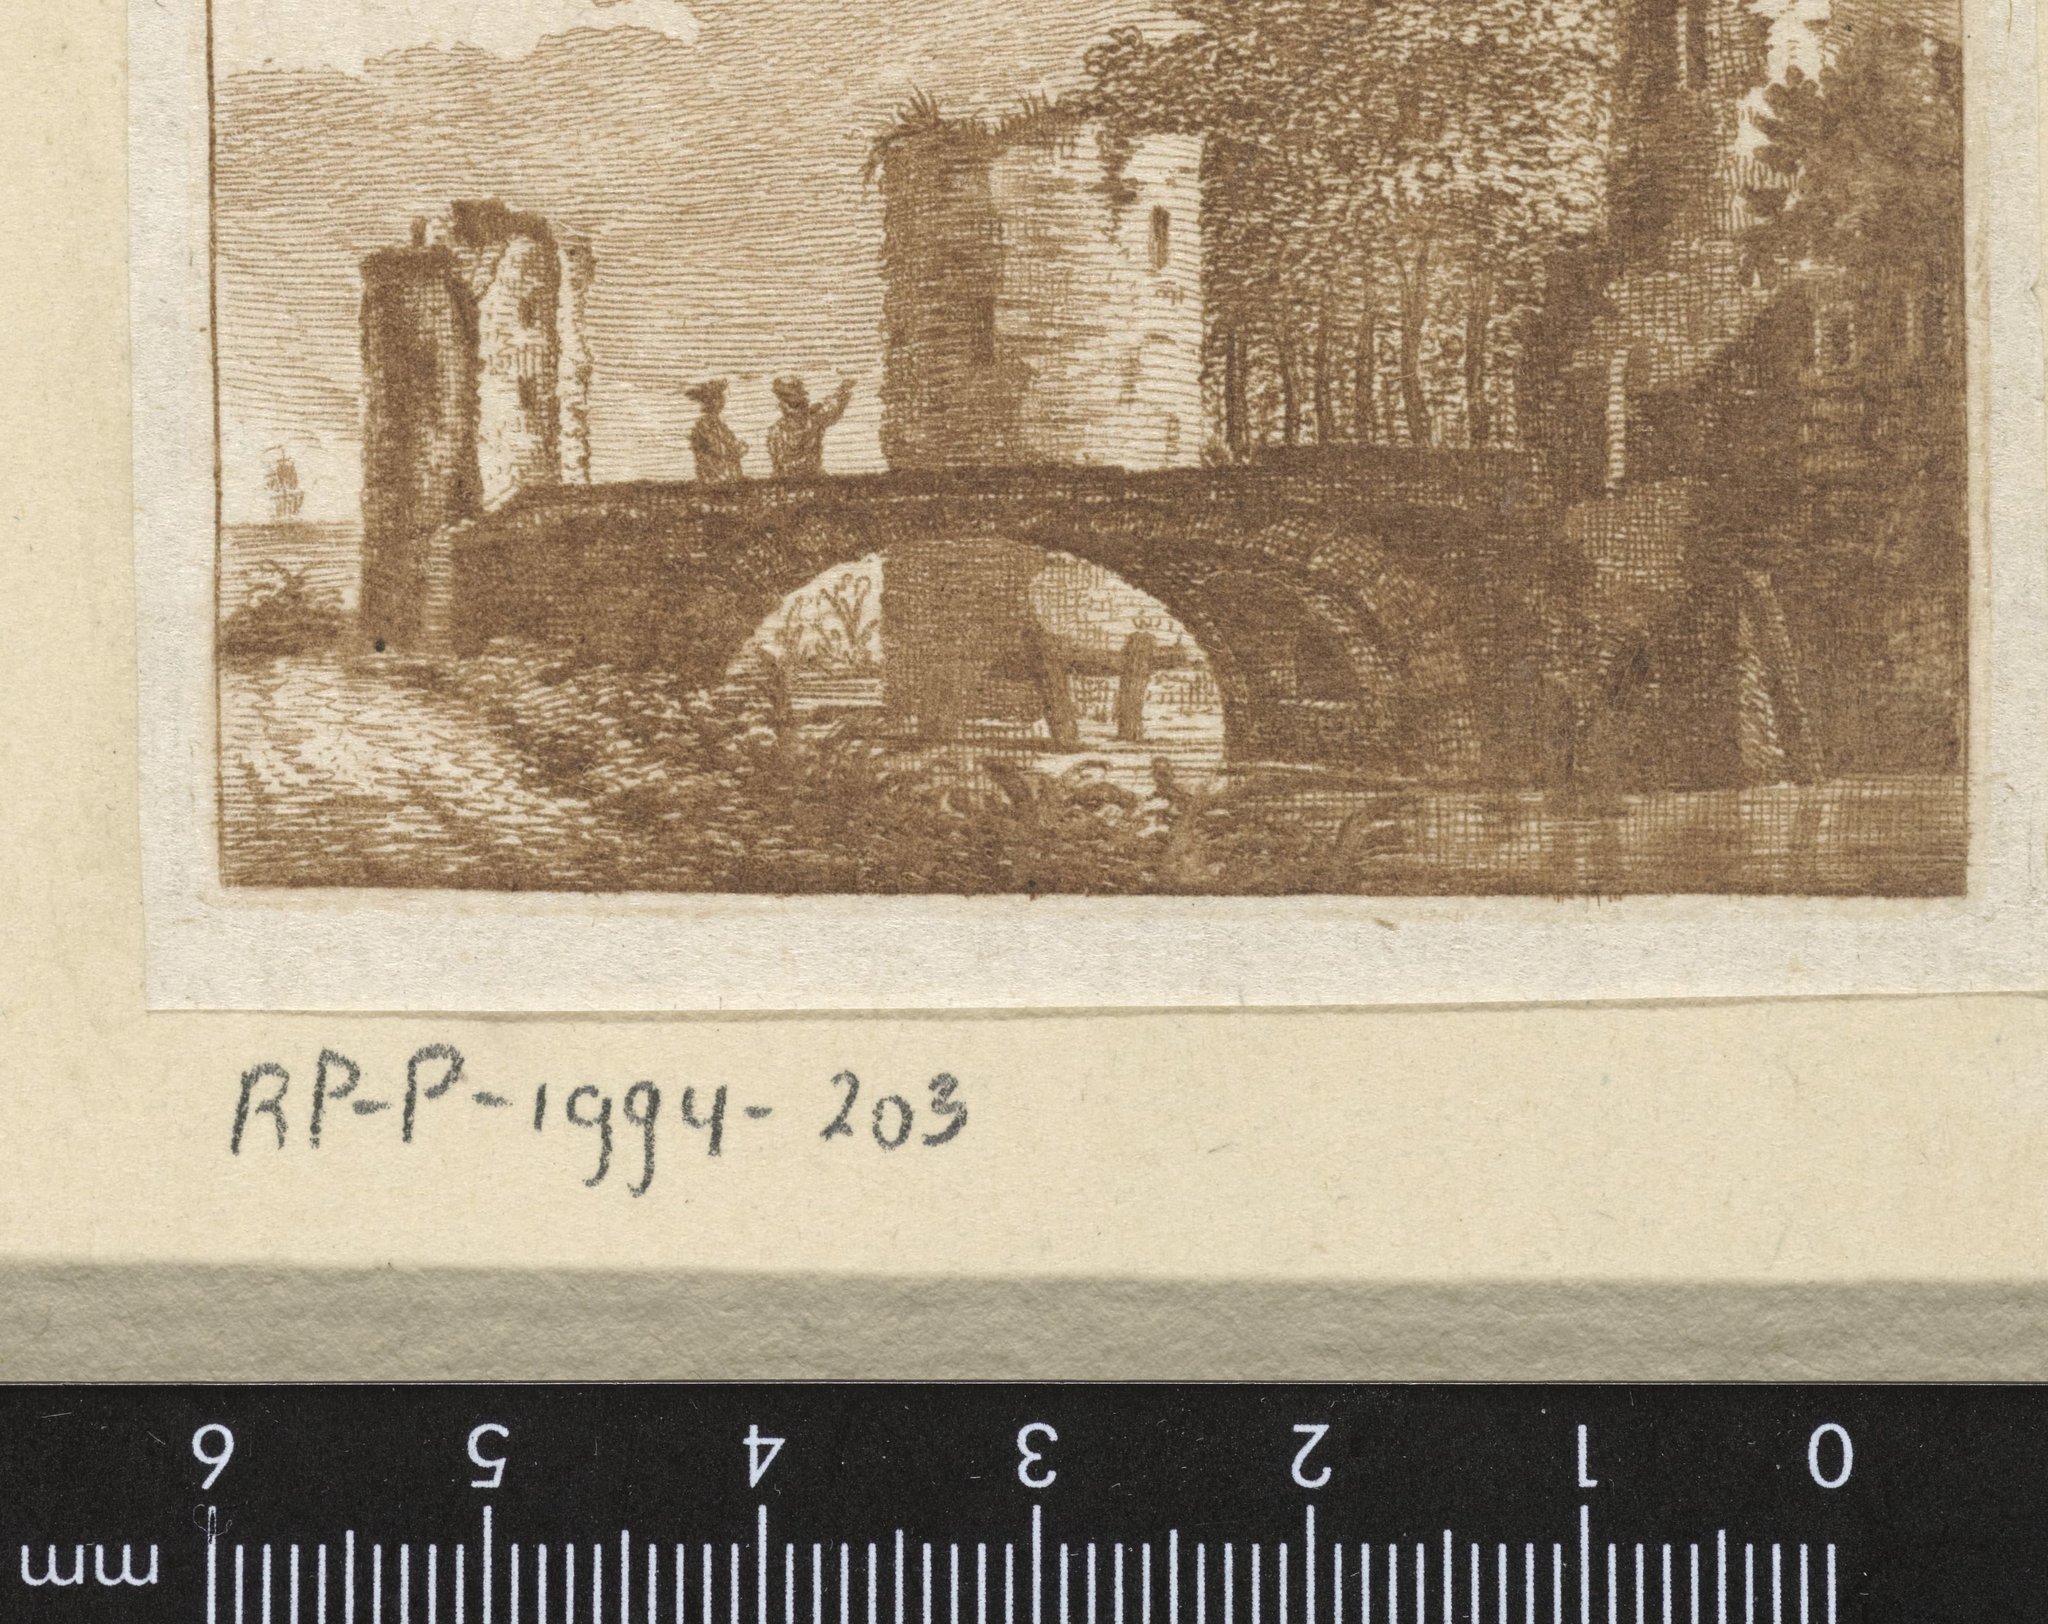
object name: print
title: Landschapjes, Rúwientjes enz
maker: caspar jacobsz. philips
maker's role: draughtsman, print maker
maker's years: 1732-1789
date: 1766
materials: paper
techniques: etching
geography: amsterdam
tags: landscape with bridge, viaduct or aqueduct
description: Landschap met de ruïne van een kasteel. In het midden twee figuren in gesprek op een boogbrug.